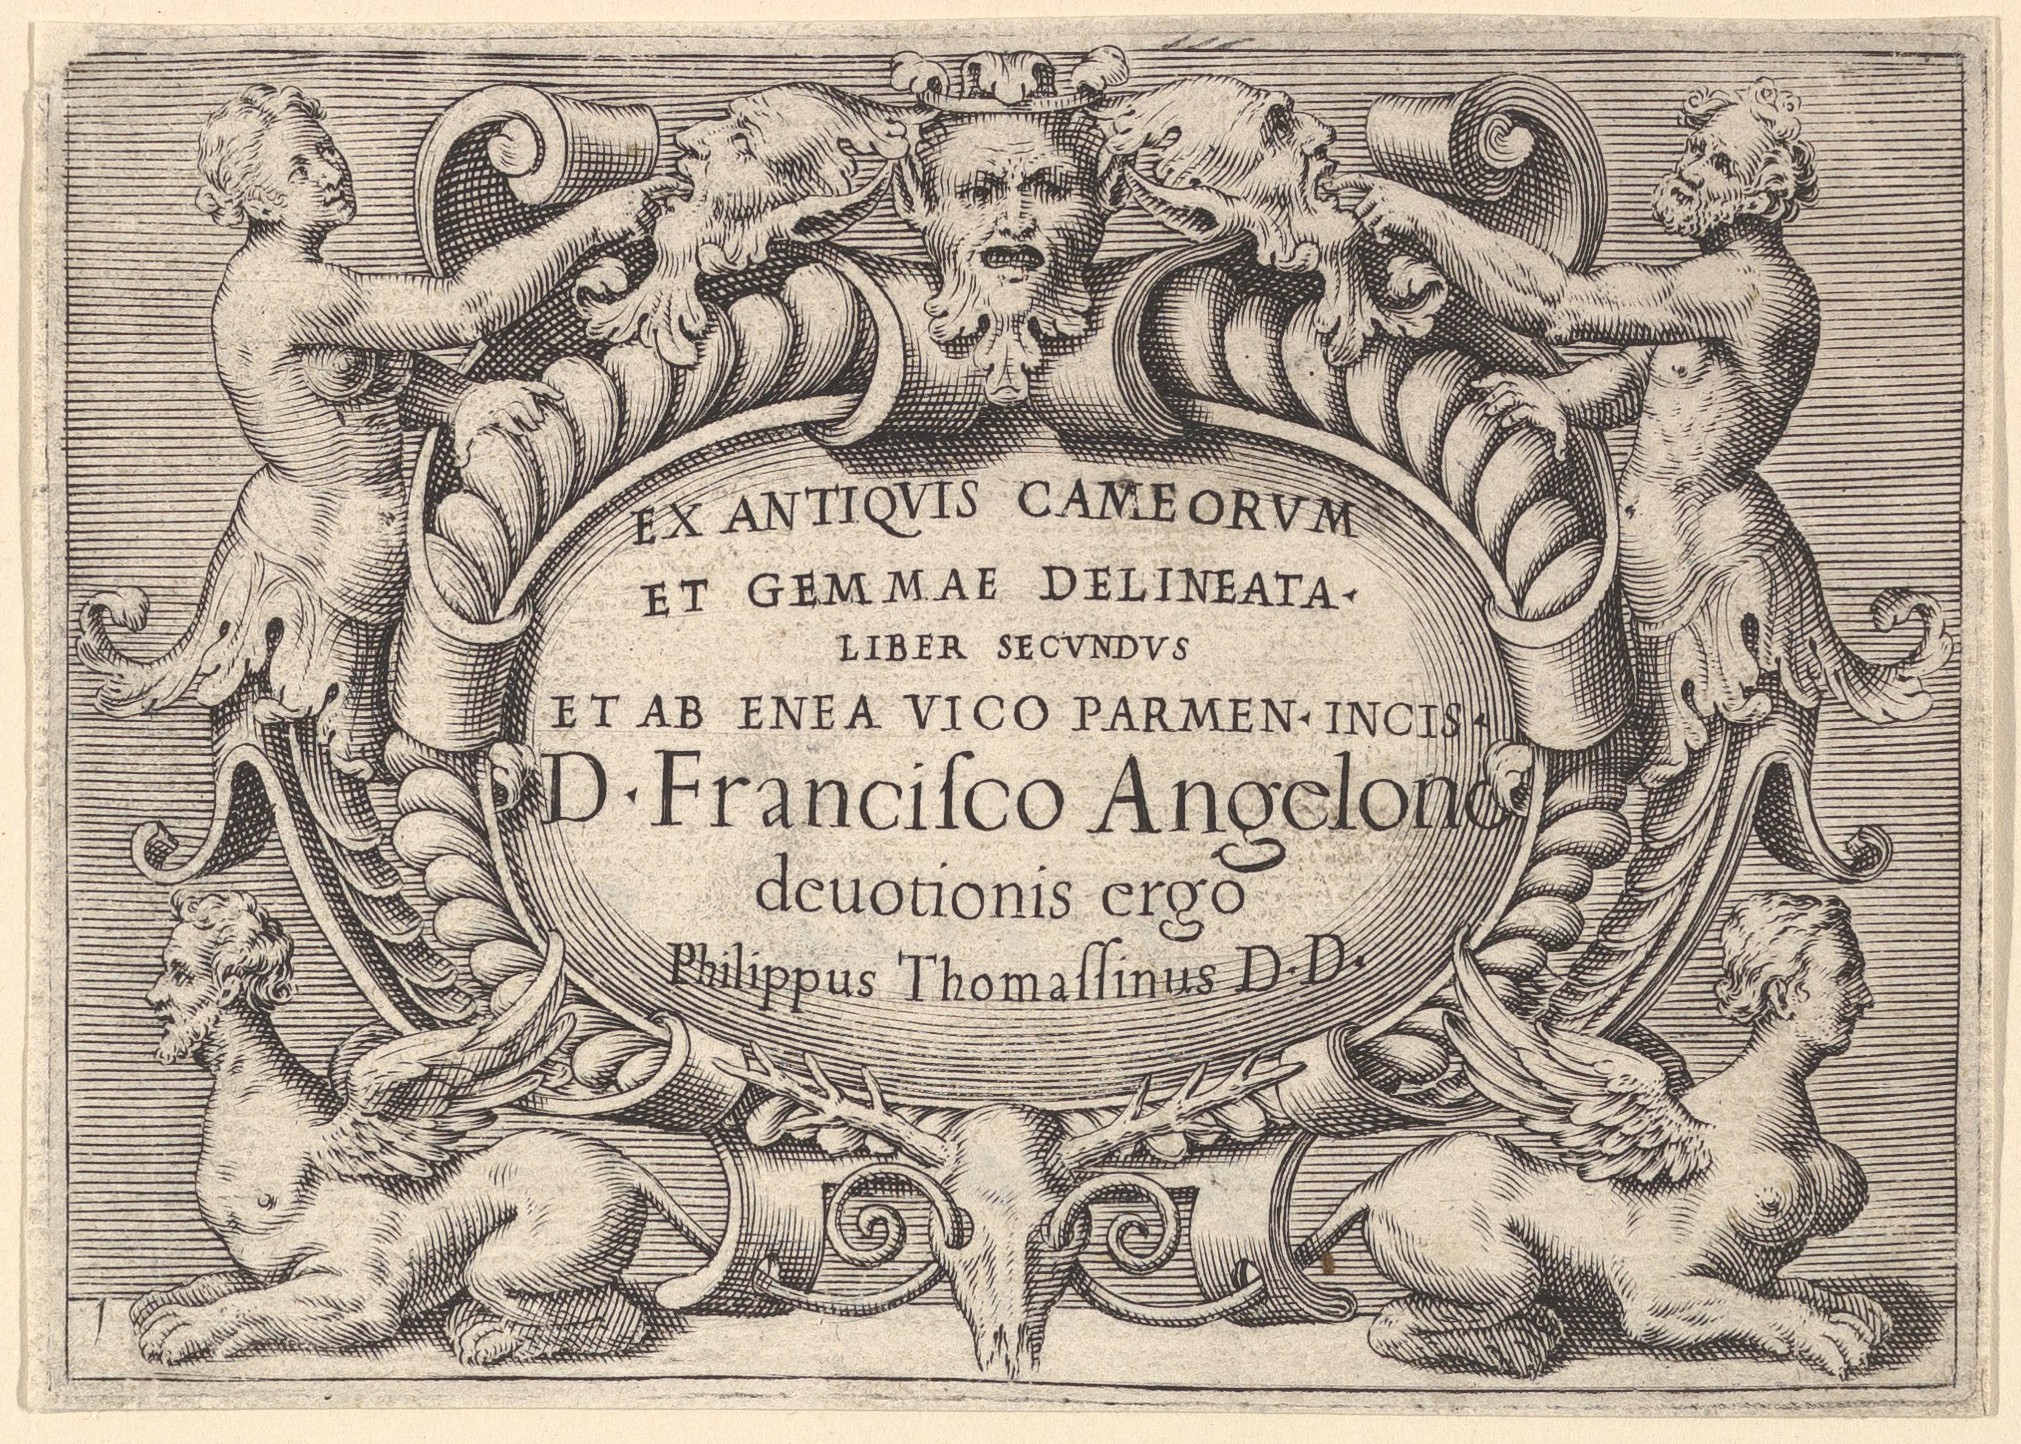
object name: print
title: Frontispiece to "Ex Antiquis Cameorum et Gemmae Delineata/ Liber Secundus/et ab Enea Vico Parmen Incis"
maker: anonymous, italian, 16th century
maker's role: artist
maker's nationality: italian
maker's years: 1500-1600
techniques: engraving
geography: rome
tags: cartouches